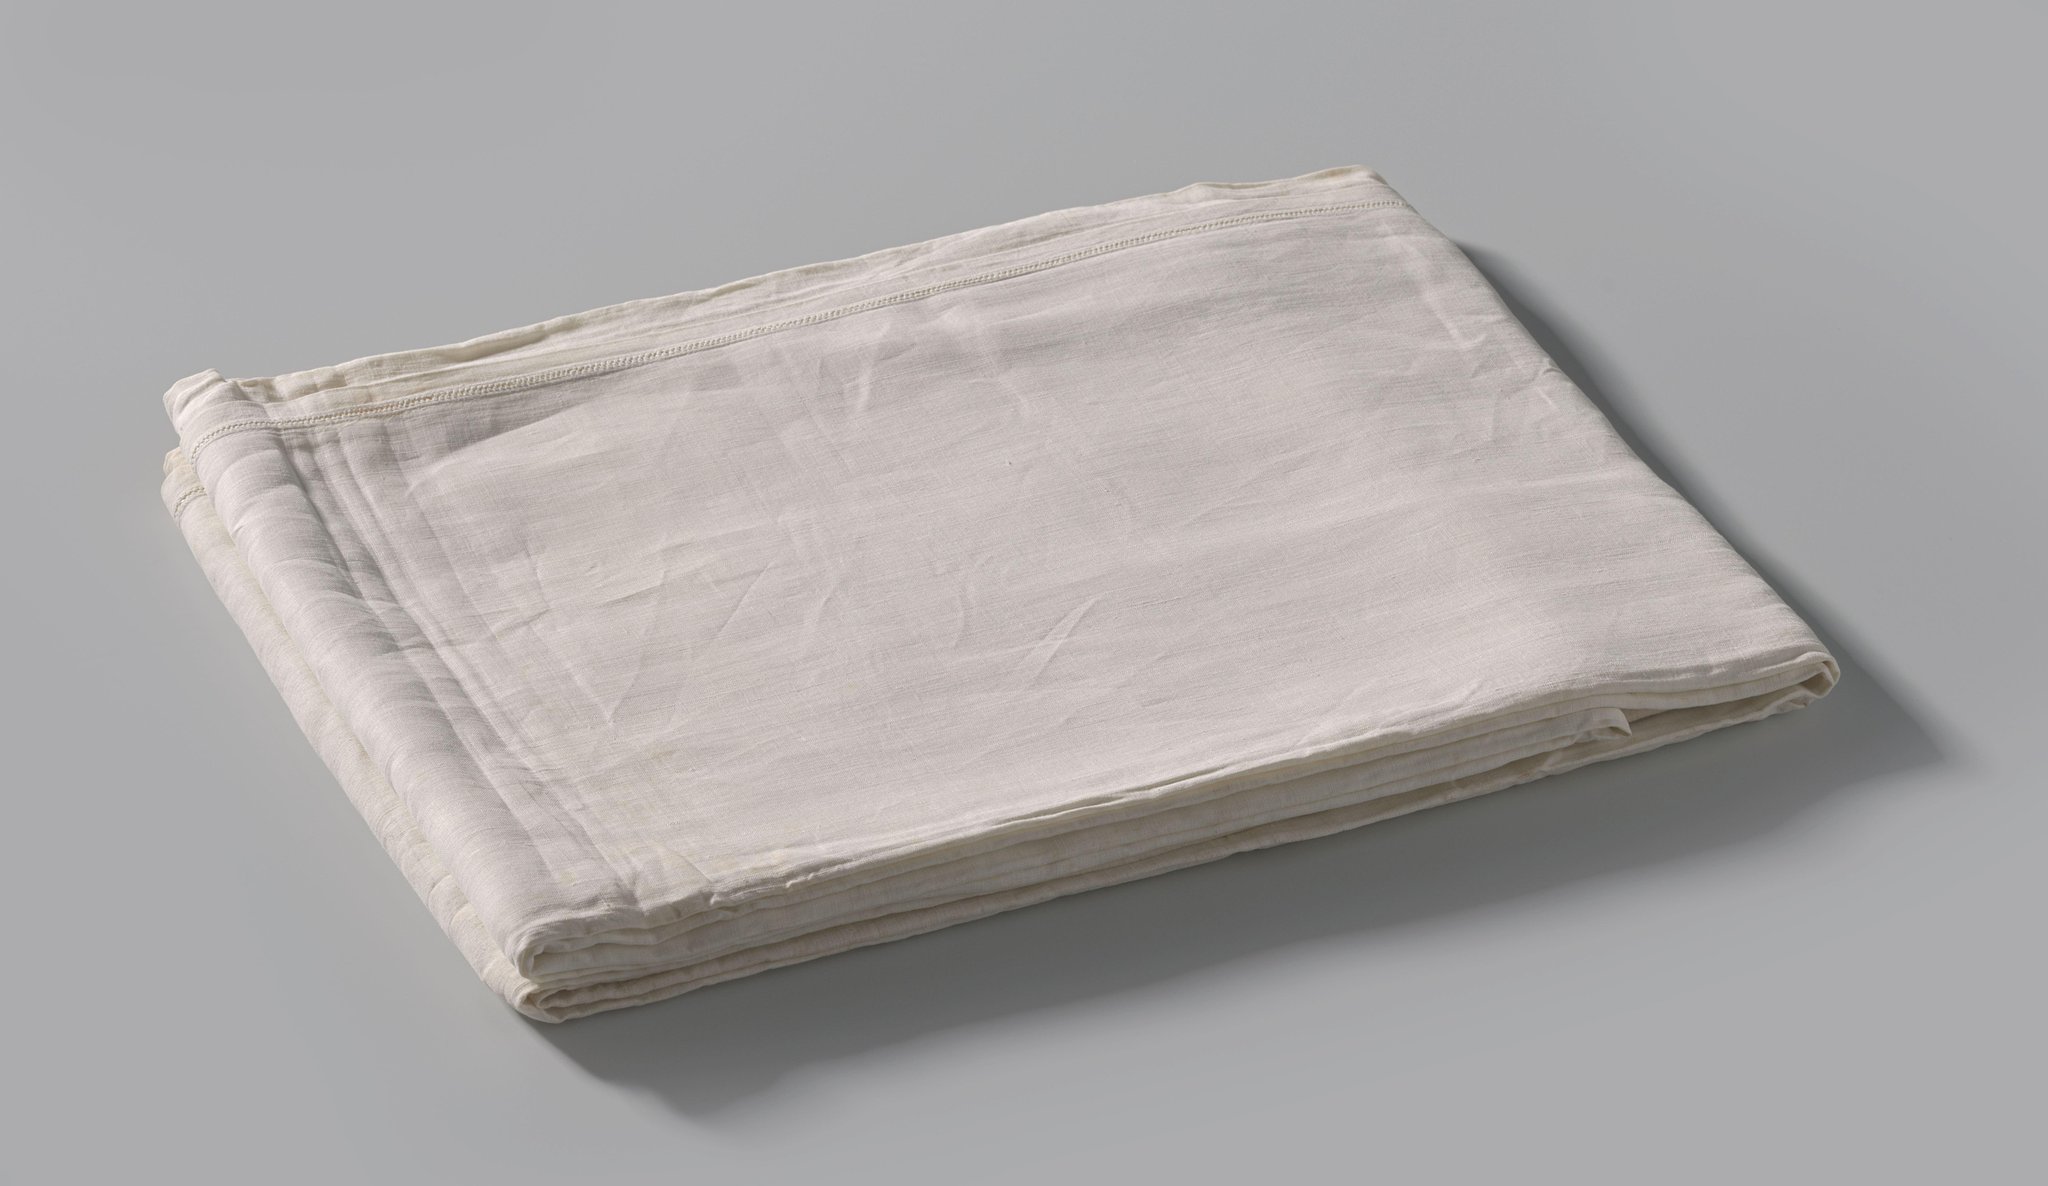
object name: beddenlaken, laken object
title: Laken. Merk: gekroonde letters AAVD en jaartal 1676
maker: Anonymous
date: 1676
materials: linen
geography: netherlands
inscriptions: mark: ‘kroon AAV(?)D 1776’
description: Laken van linnen, gemerkt in bindgat: gekroonde A.A.V.D. en 1676.